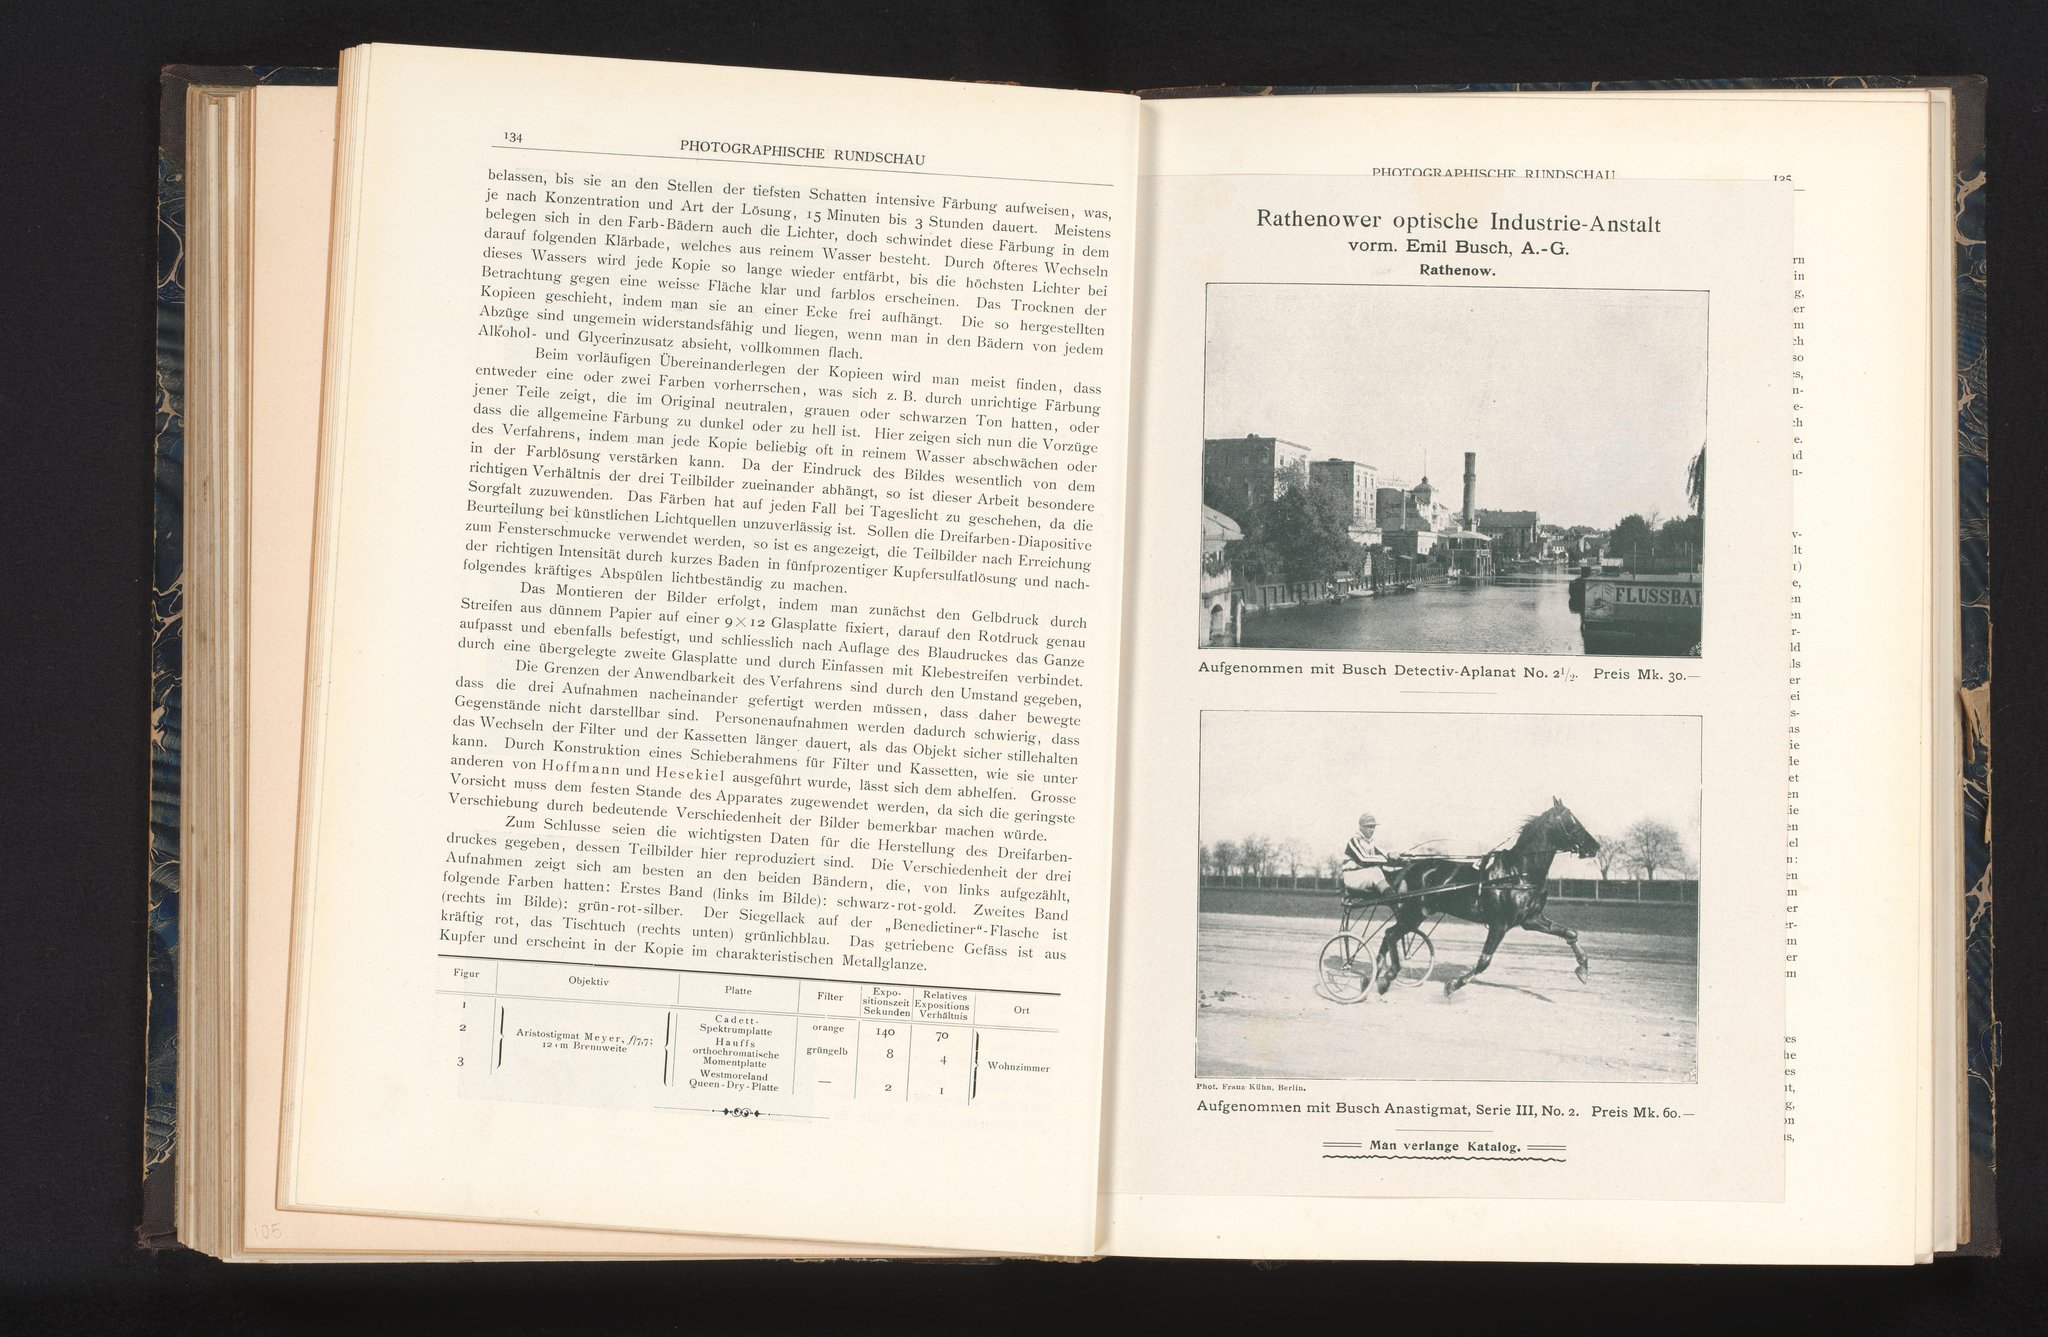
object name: photomechanical print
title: Gezicht op een rennend paard en een jockey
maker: Anonymous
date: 1897-1902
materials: paper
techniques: autotype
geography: berlin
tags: horse-racing, jockey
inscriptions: inscription: ‘Rathenower optische Industrie-Anstalt/ vorm. Emil Busch (...)’